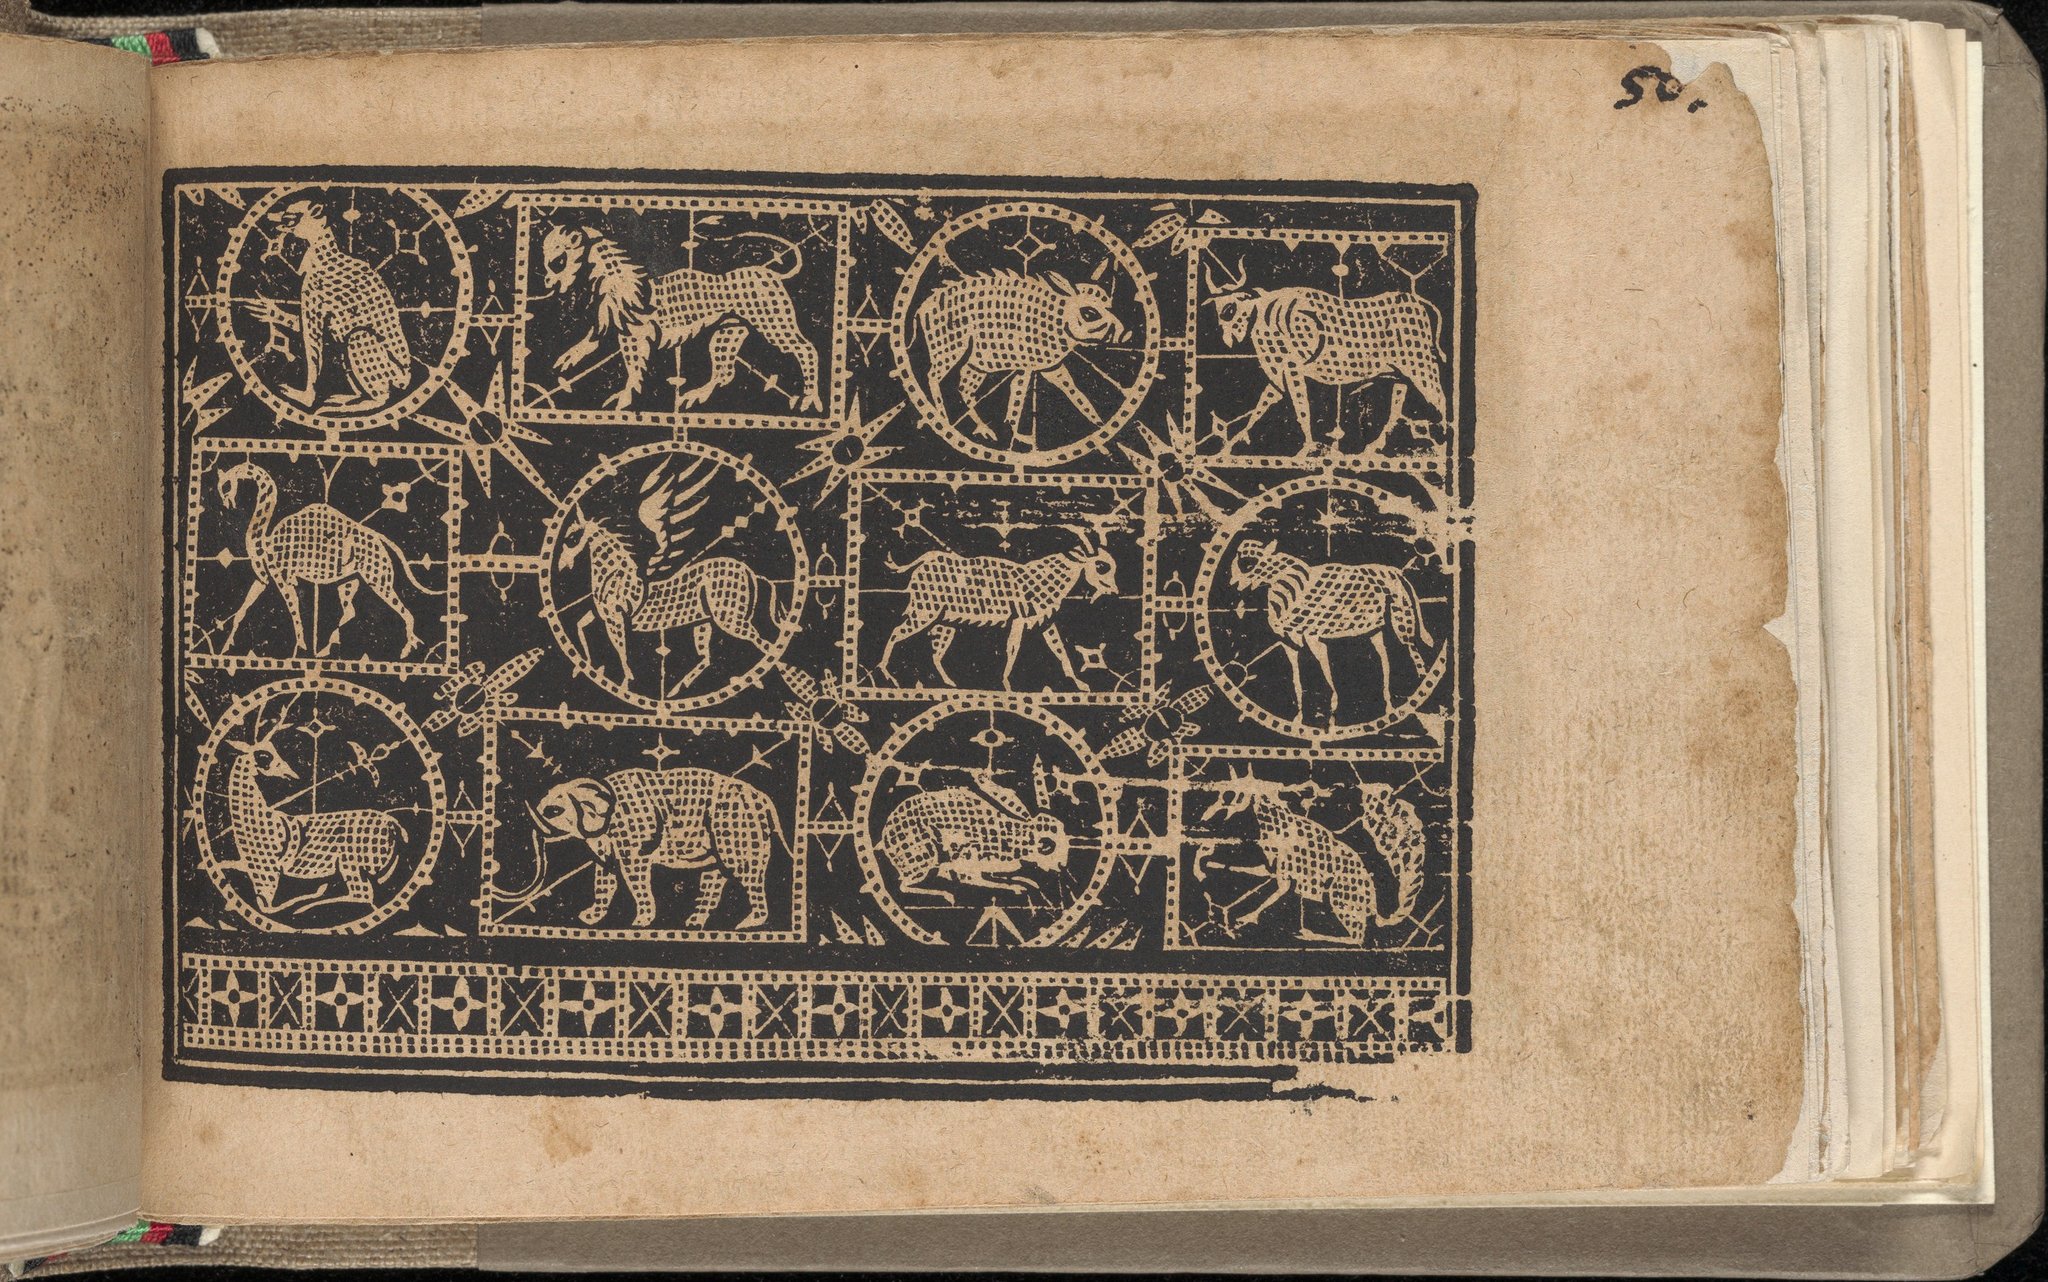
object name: book print ornament architecture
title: Schön newes Modelbuch (Page 50r)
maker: sigismundus latomus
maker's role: publisher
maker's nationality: german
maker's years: 1599-1632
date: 1608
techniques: woodcut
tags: deer,elephants,lions,rabbits